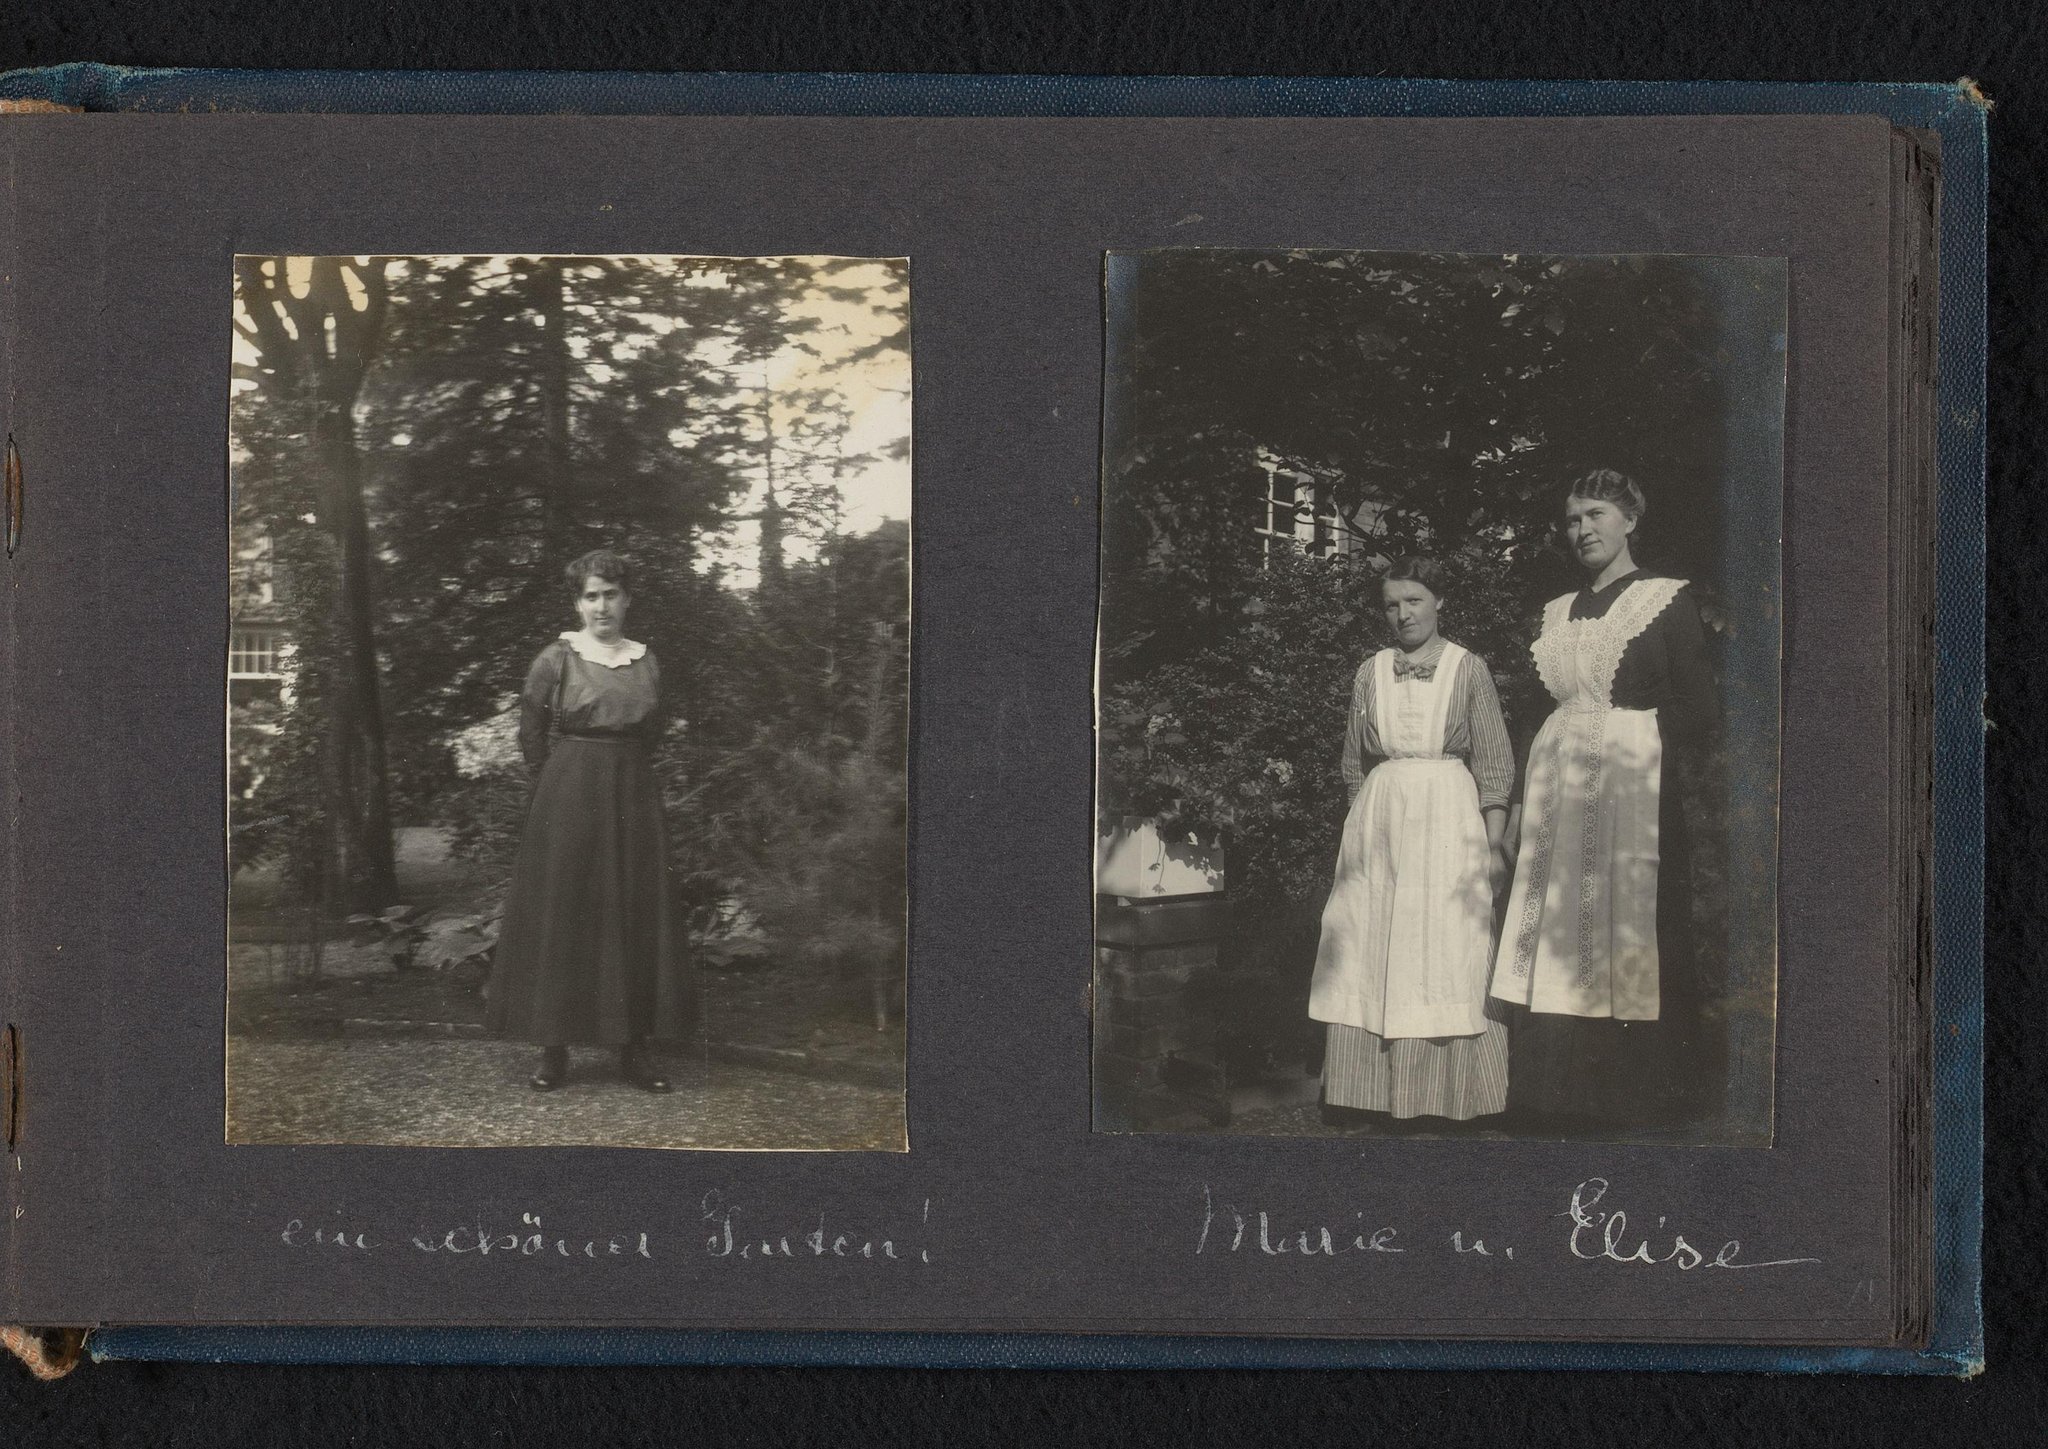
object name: photograph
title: Else en vriendinnen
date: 1916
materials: paper, photographic support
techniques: gelatin silver print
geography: germany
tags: else wachenheimer-moos, historical persons - bb - woman, germany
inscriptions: inscription: ‘ein ... Garten! / Marie u. Elise’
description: Albumblad met twee foto's van Else en van twee vriendinnen. Onderdeel van het fotoalbum van Else Wachenheimer-Moos en haar broers Arthur en Willy Moos en anderen in de periode 1913-1918.